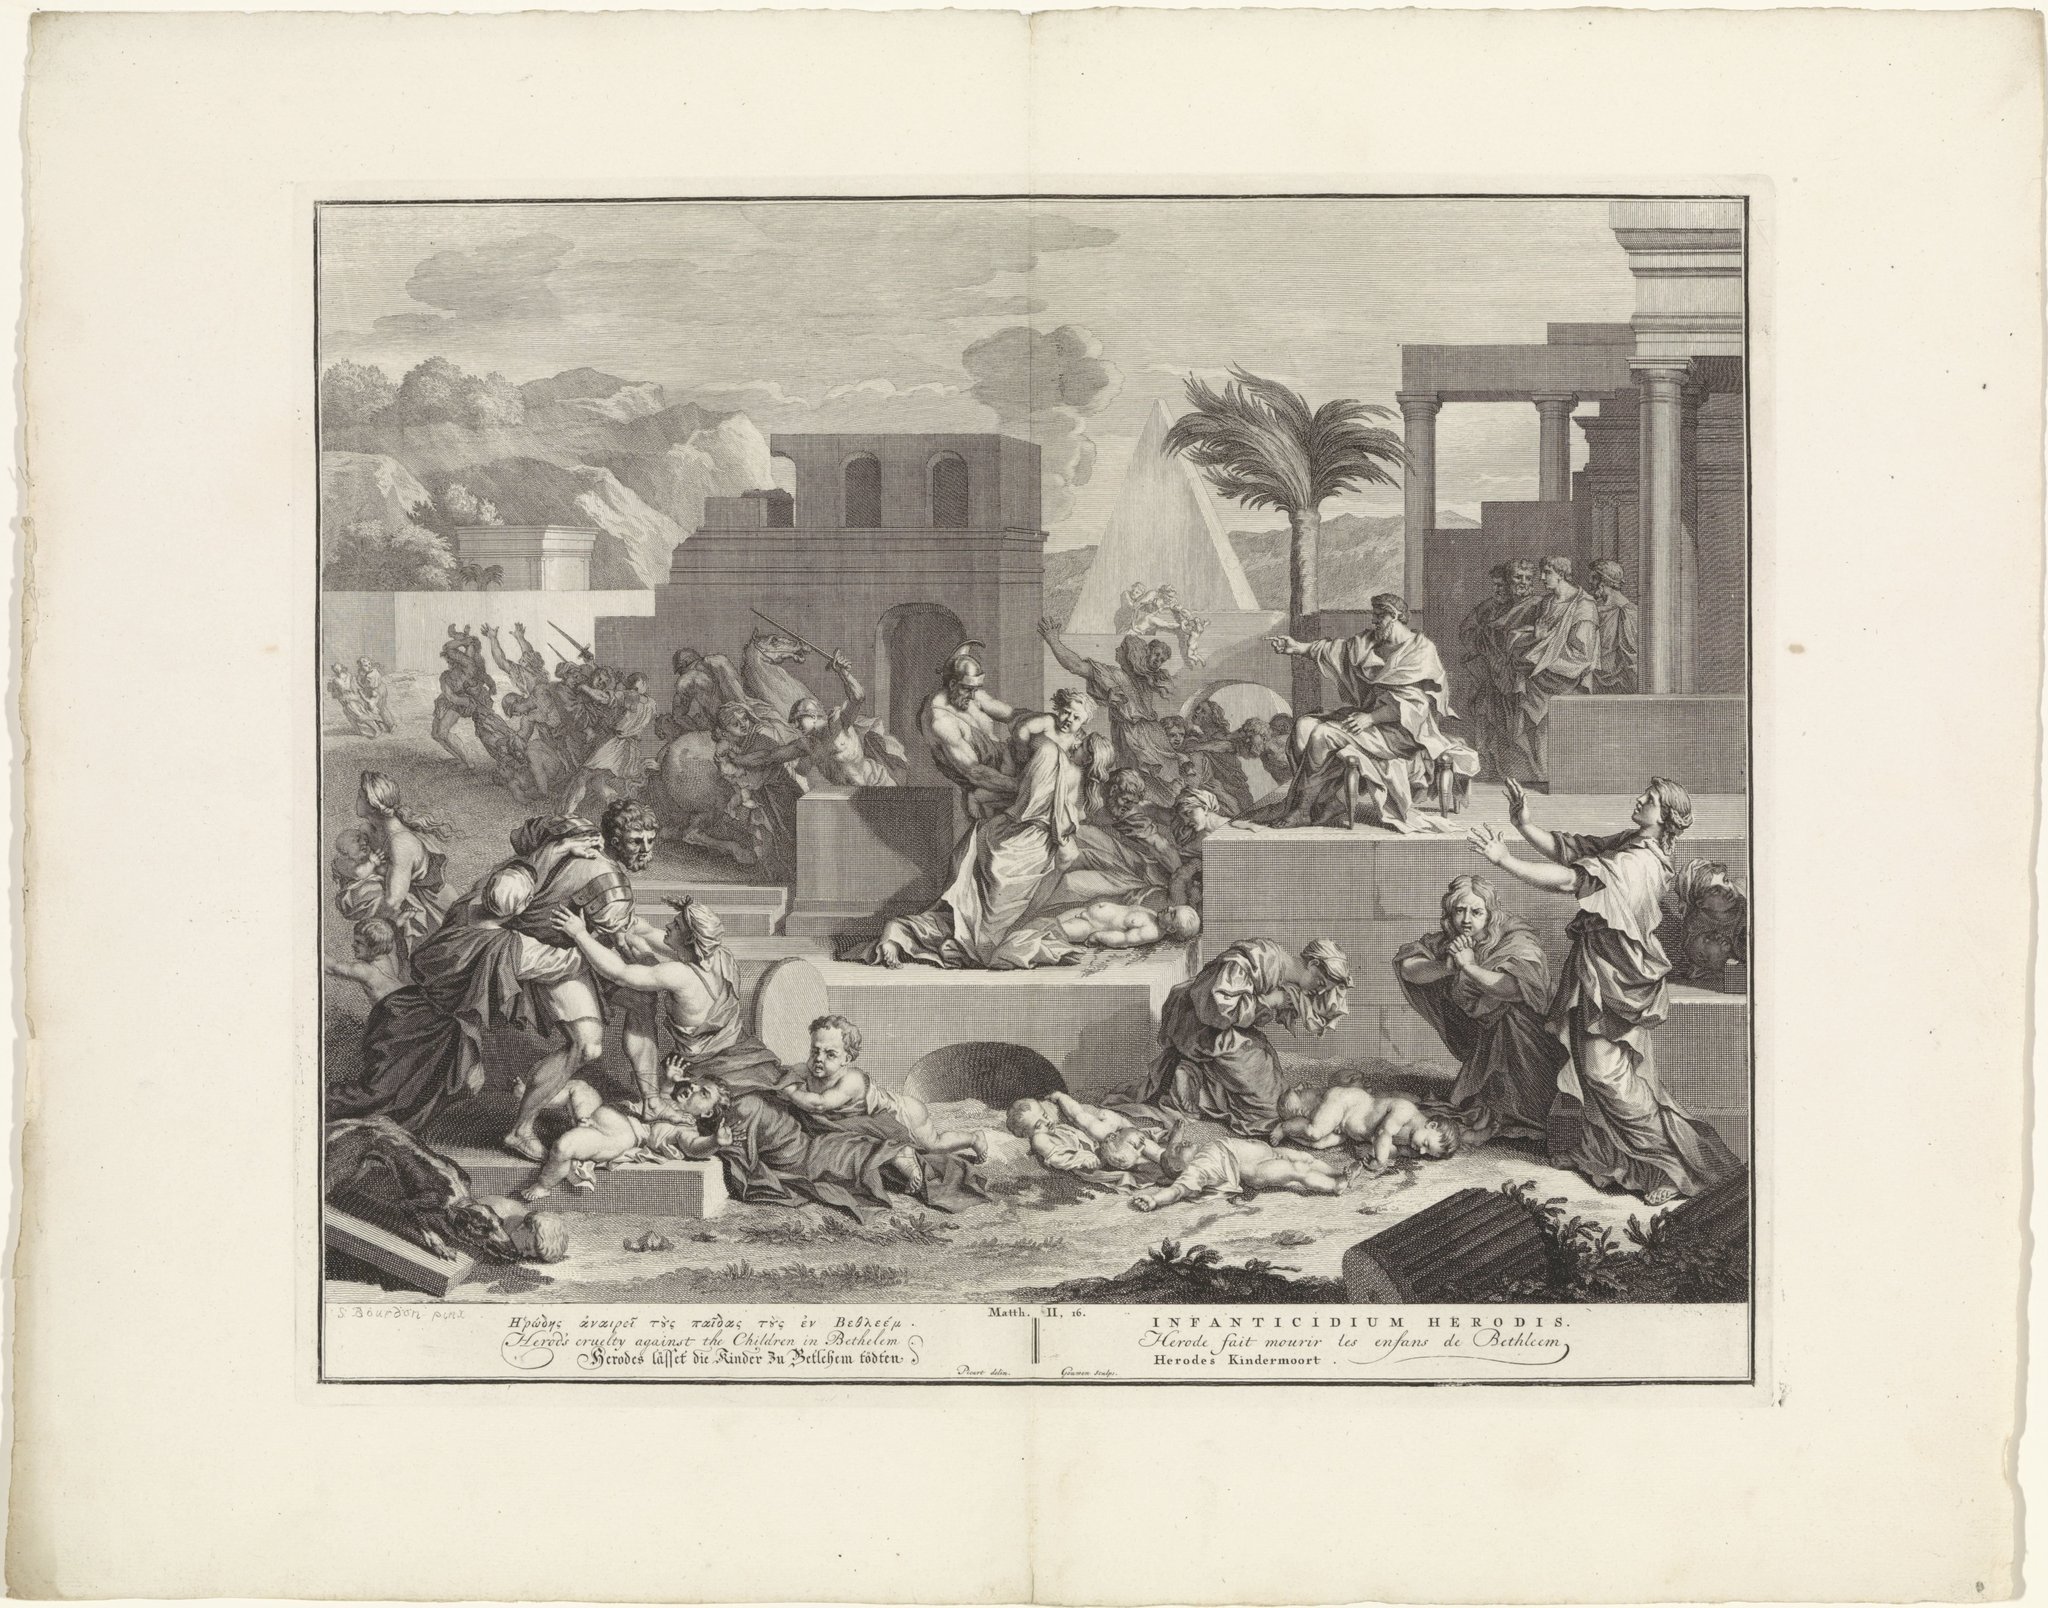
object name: print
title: Kindermoord van Bethlehem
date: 1728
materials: paper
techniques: engraving, etching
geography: the hague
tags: herod gives orders to slay the children, the massacre of the innocents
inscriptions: inscription: ‘utrecht fundatiehuys’, collector's mark: Lugt 2228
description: De soldaten van Herodes vermoorden alle jongens van twee jaar en jonger in Betlehem. De moeders proberen hun kinderen te beschermen. Rechts op het bordes geeft Herodes het bevel tot het bloedbad. (Mat. 2:16). De prent heeft een Hebreeuws, Latijns, Frans, Engels, Duits en Nederlands onderschrift.